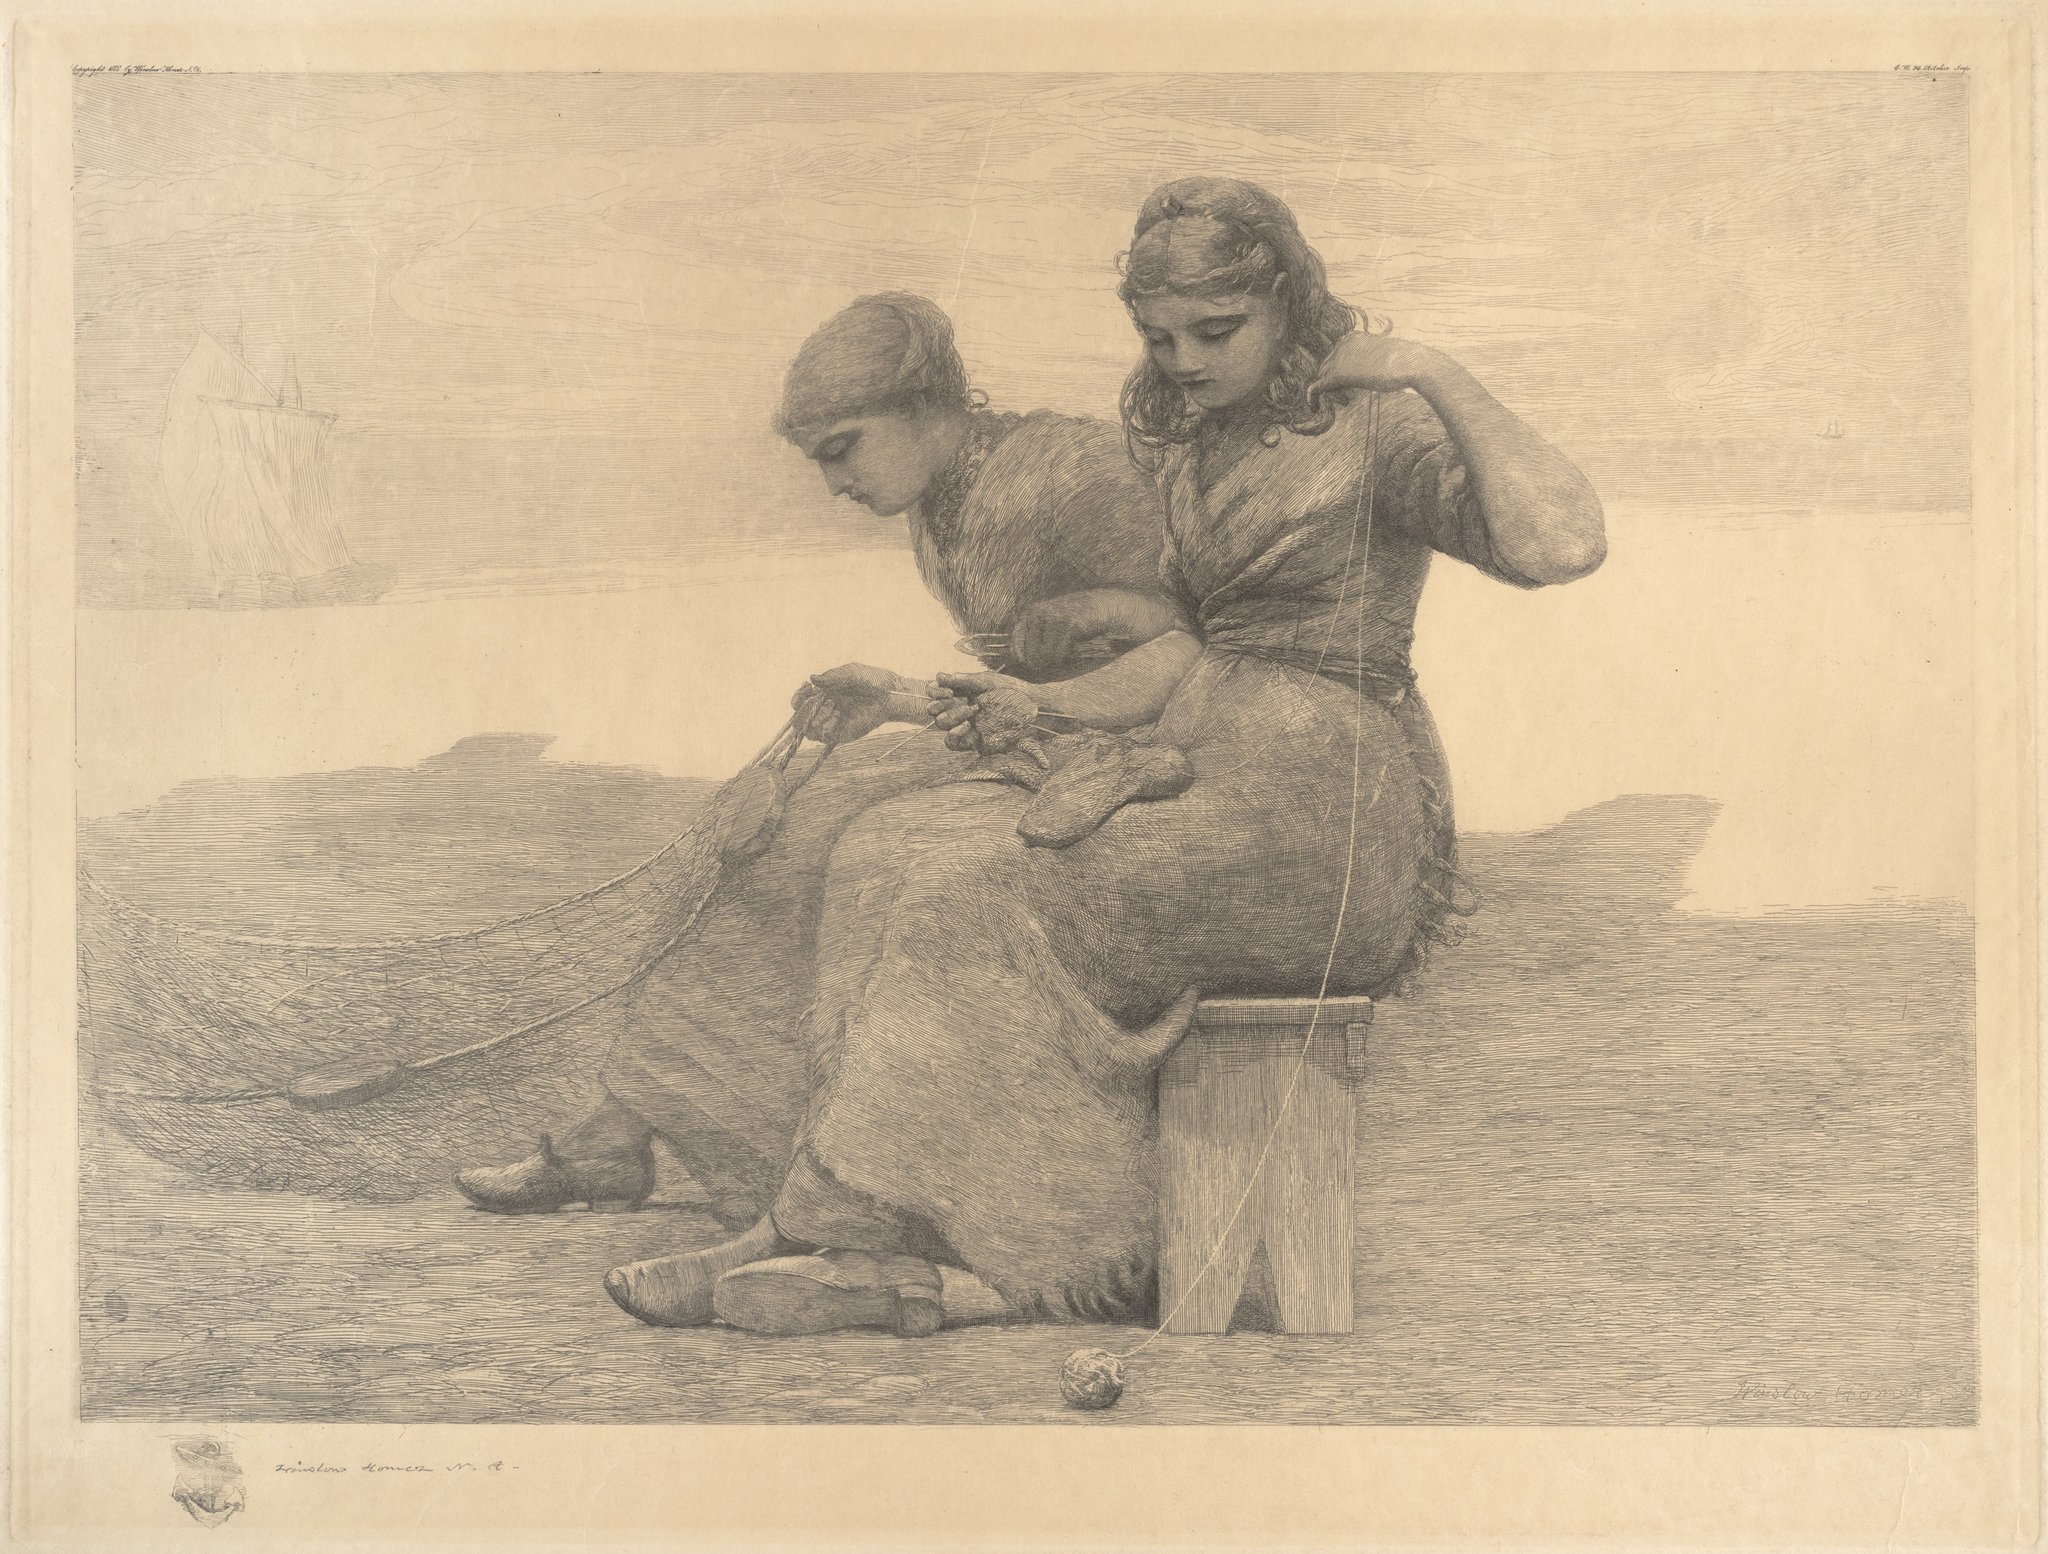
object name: print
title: Mending the Tears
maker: winslow homer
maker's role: artist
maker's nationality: american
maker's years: 1836-1910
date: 1888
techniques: etching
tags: women